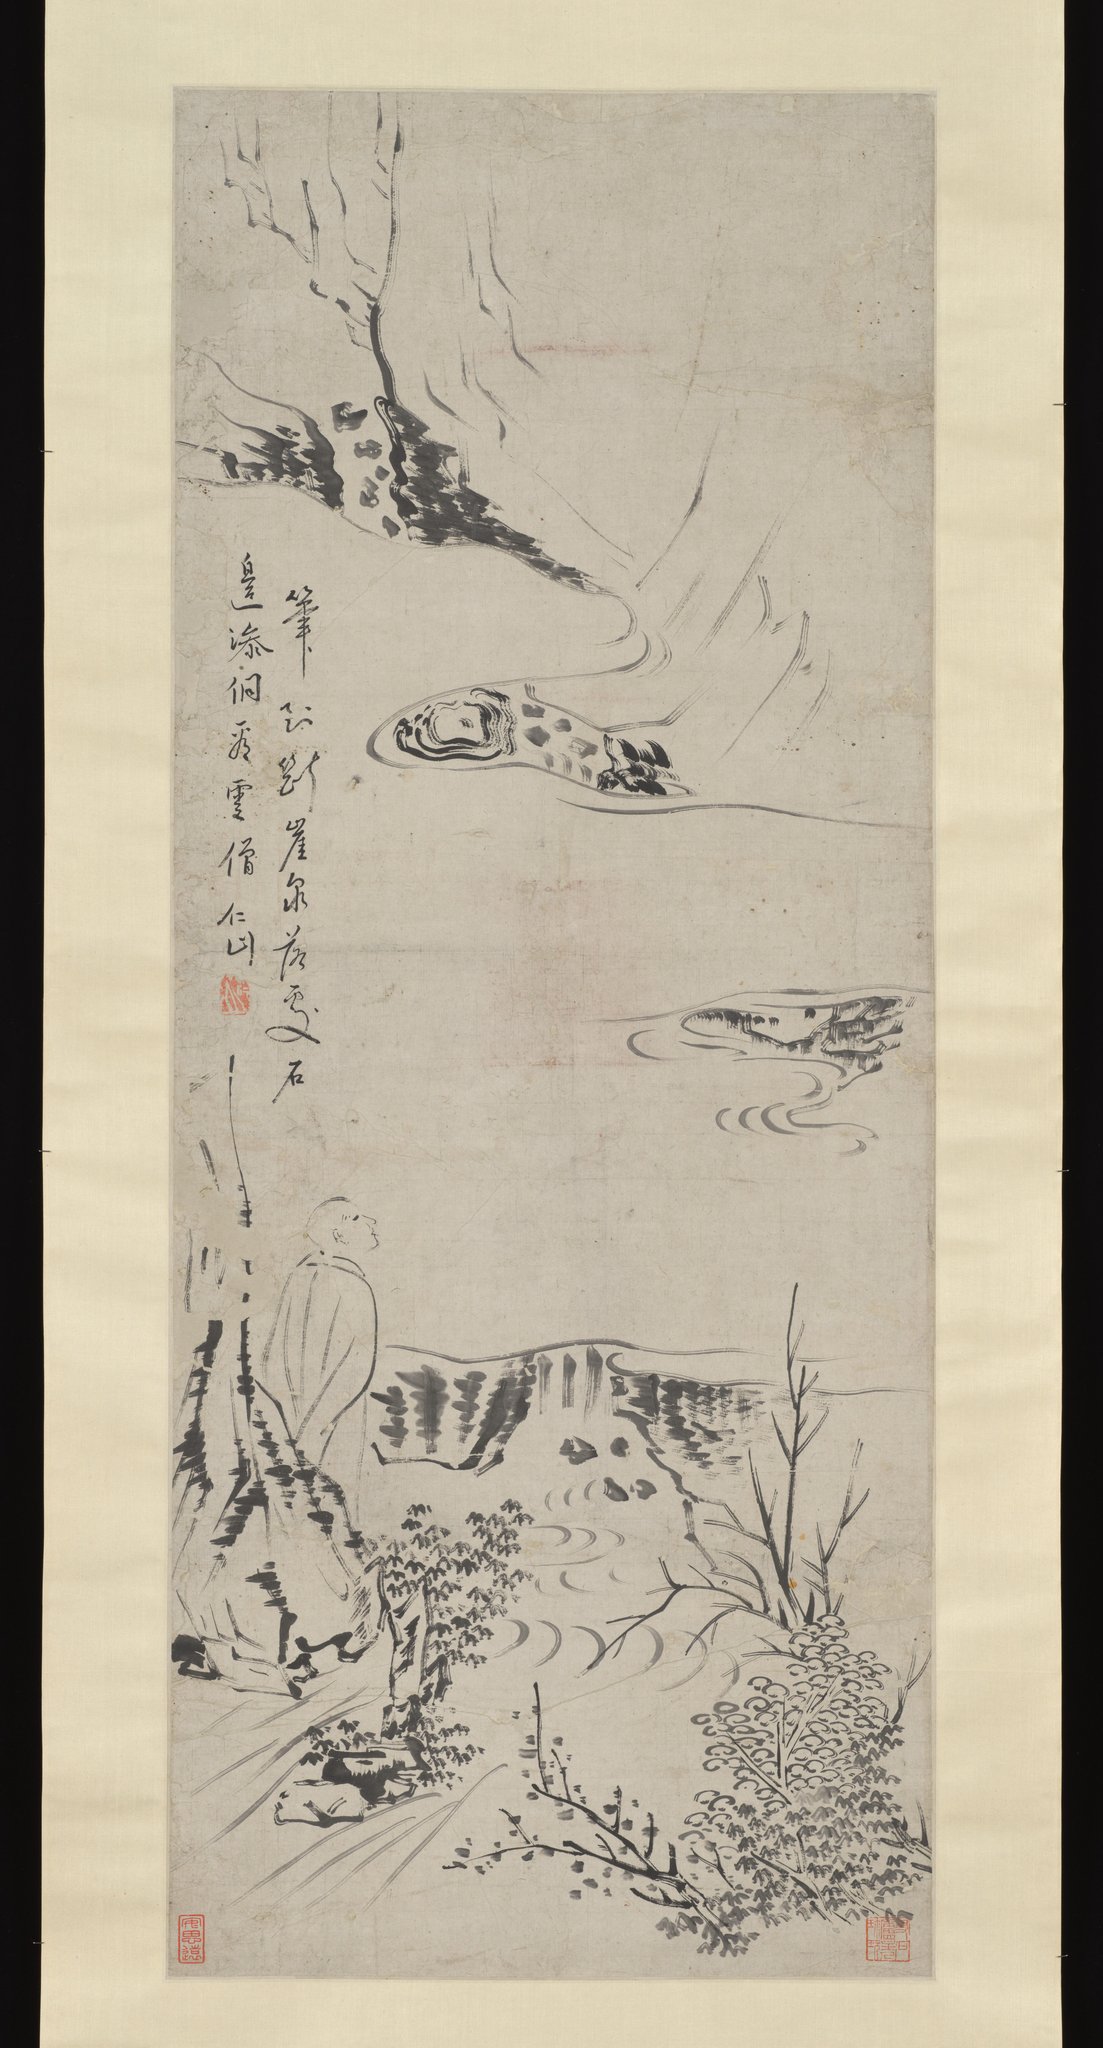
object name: hanging scroll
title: Monk Gazing at Clouds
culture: chinese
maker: su renshan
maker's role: artist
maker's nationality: chinese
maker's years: 1814-1850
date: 1814-1849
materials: ink, paper